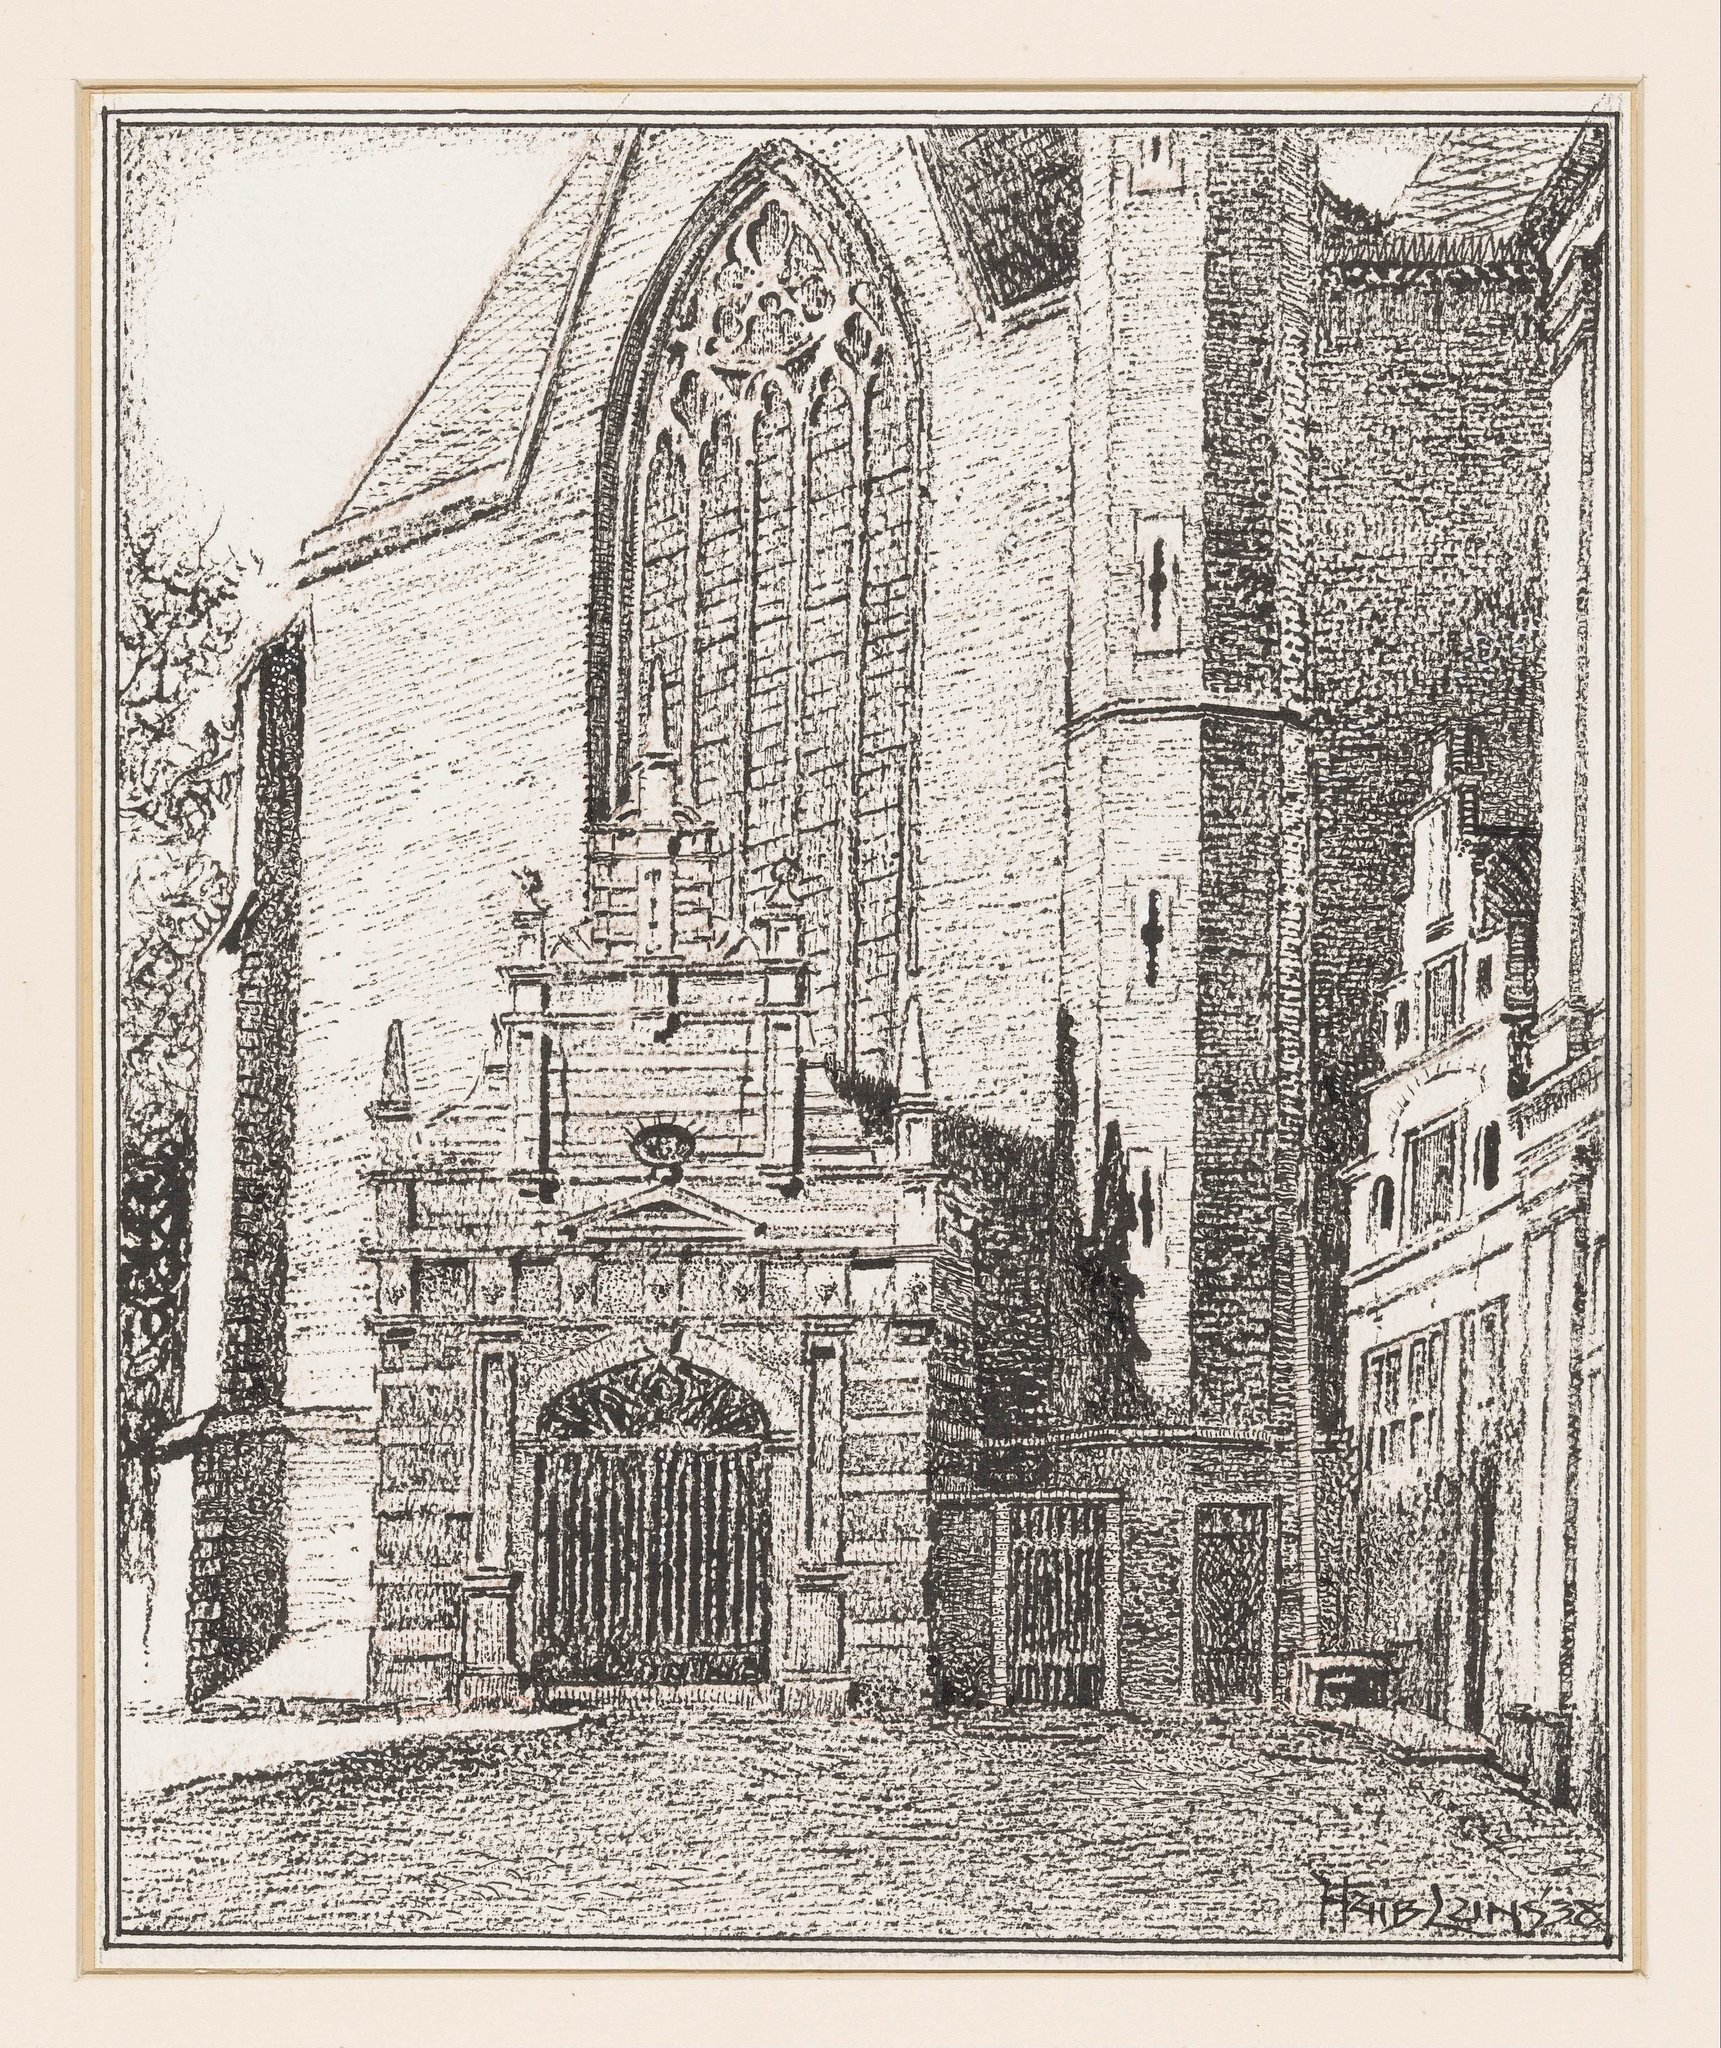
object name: drawing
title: Portaal van de Sint-Gommaruskerk te Enkhuizen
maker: huib luns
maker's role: draughtsman, print maker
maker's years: 1881-1942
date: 1938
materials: paint, ink, paper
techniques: brush, pen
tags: church (exterior), enkhuizen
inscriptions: collector's mark: Lugt 2228